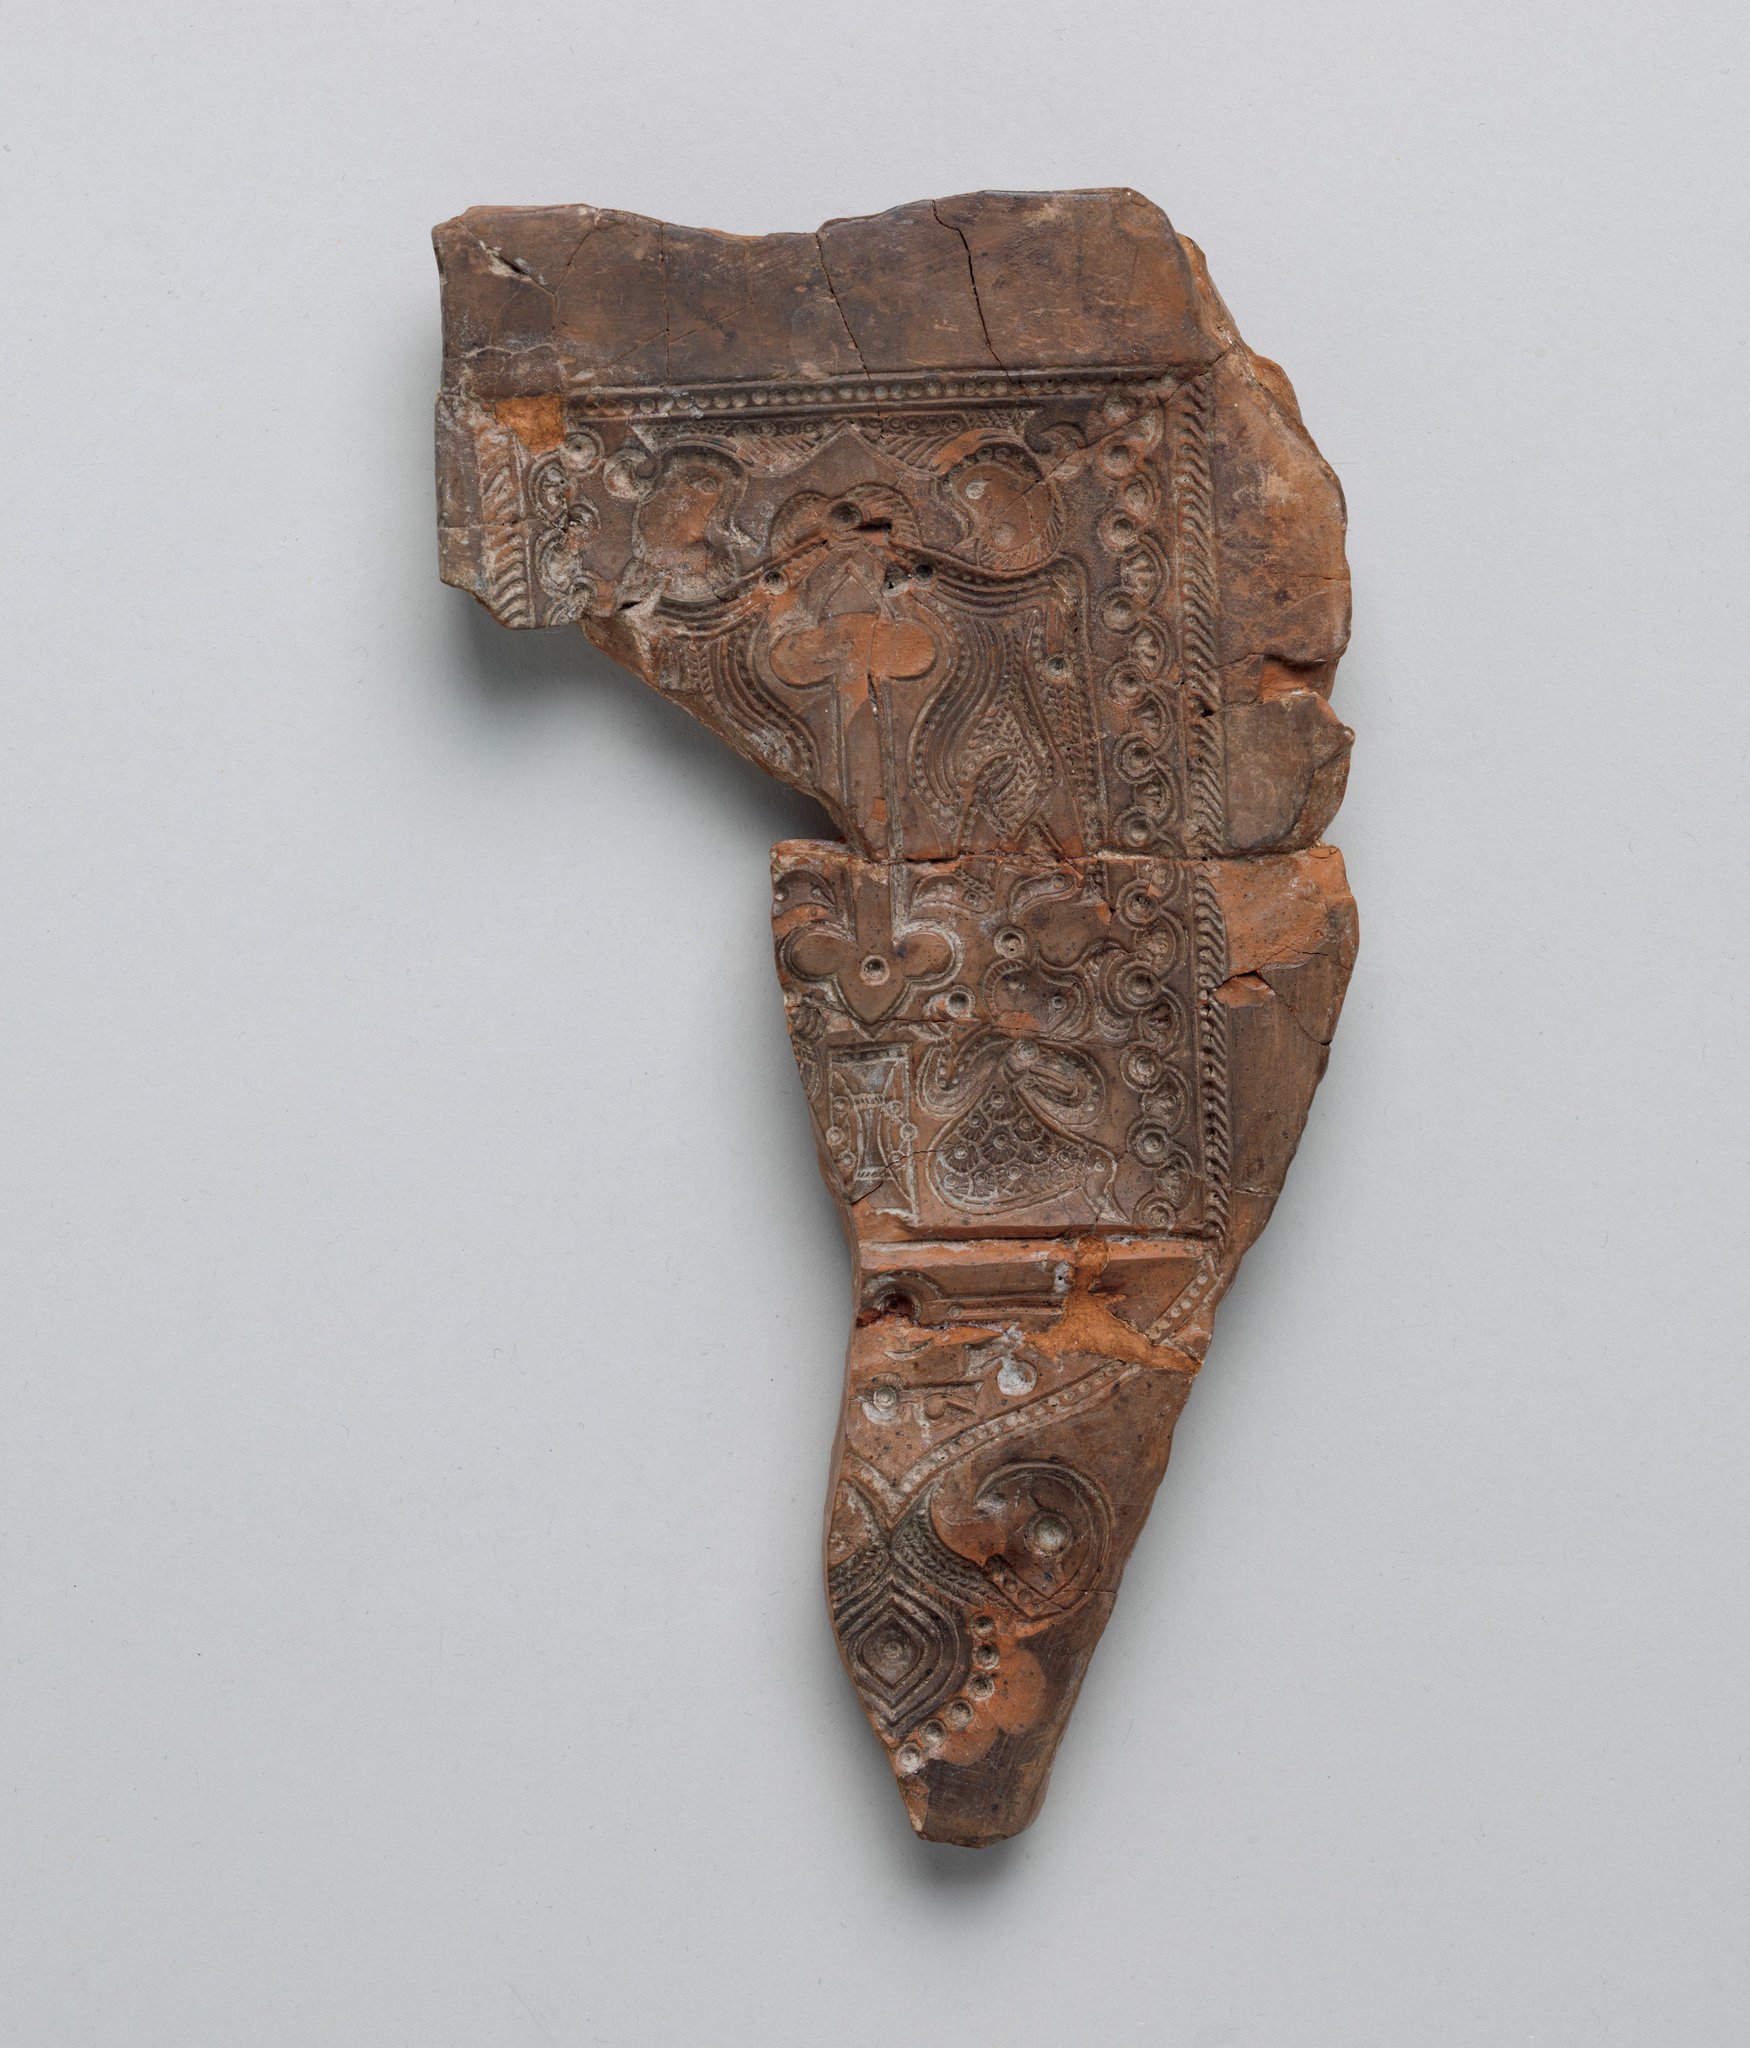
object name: mold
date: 867-933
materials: earthenware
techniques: incising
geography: iran